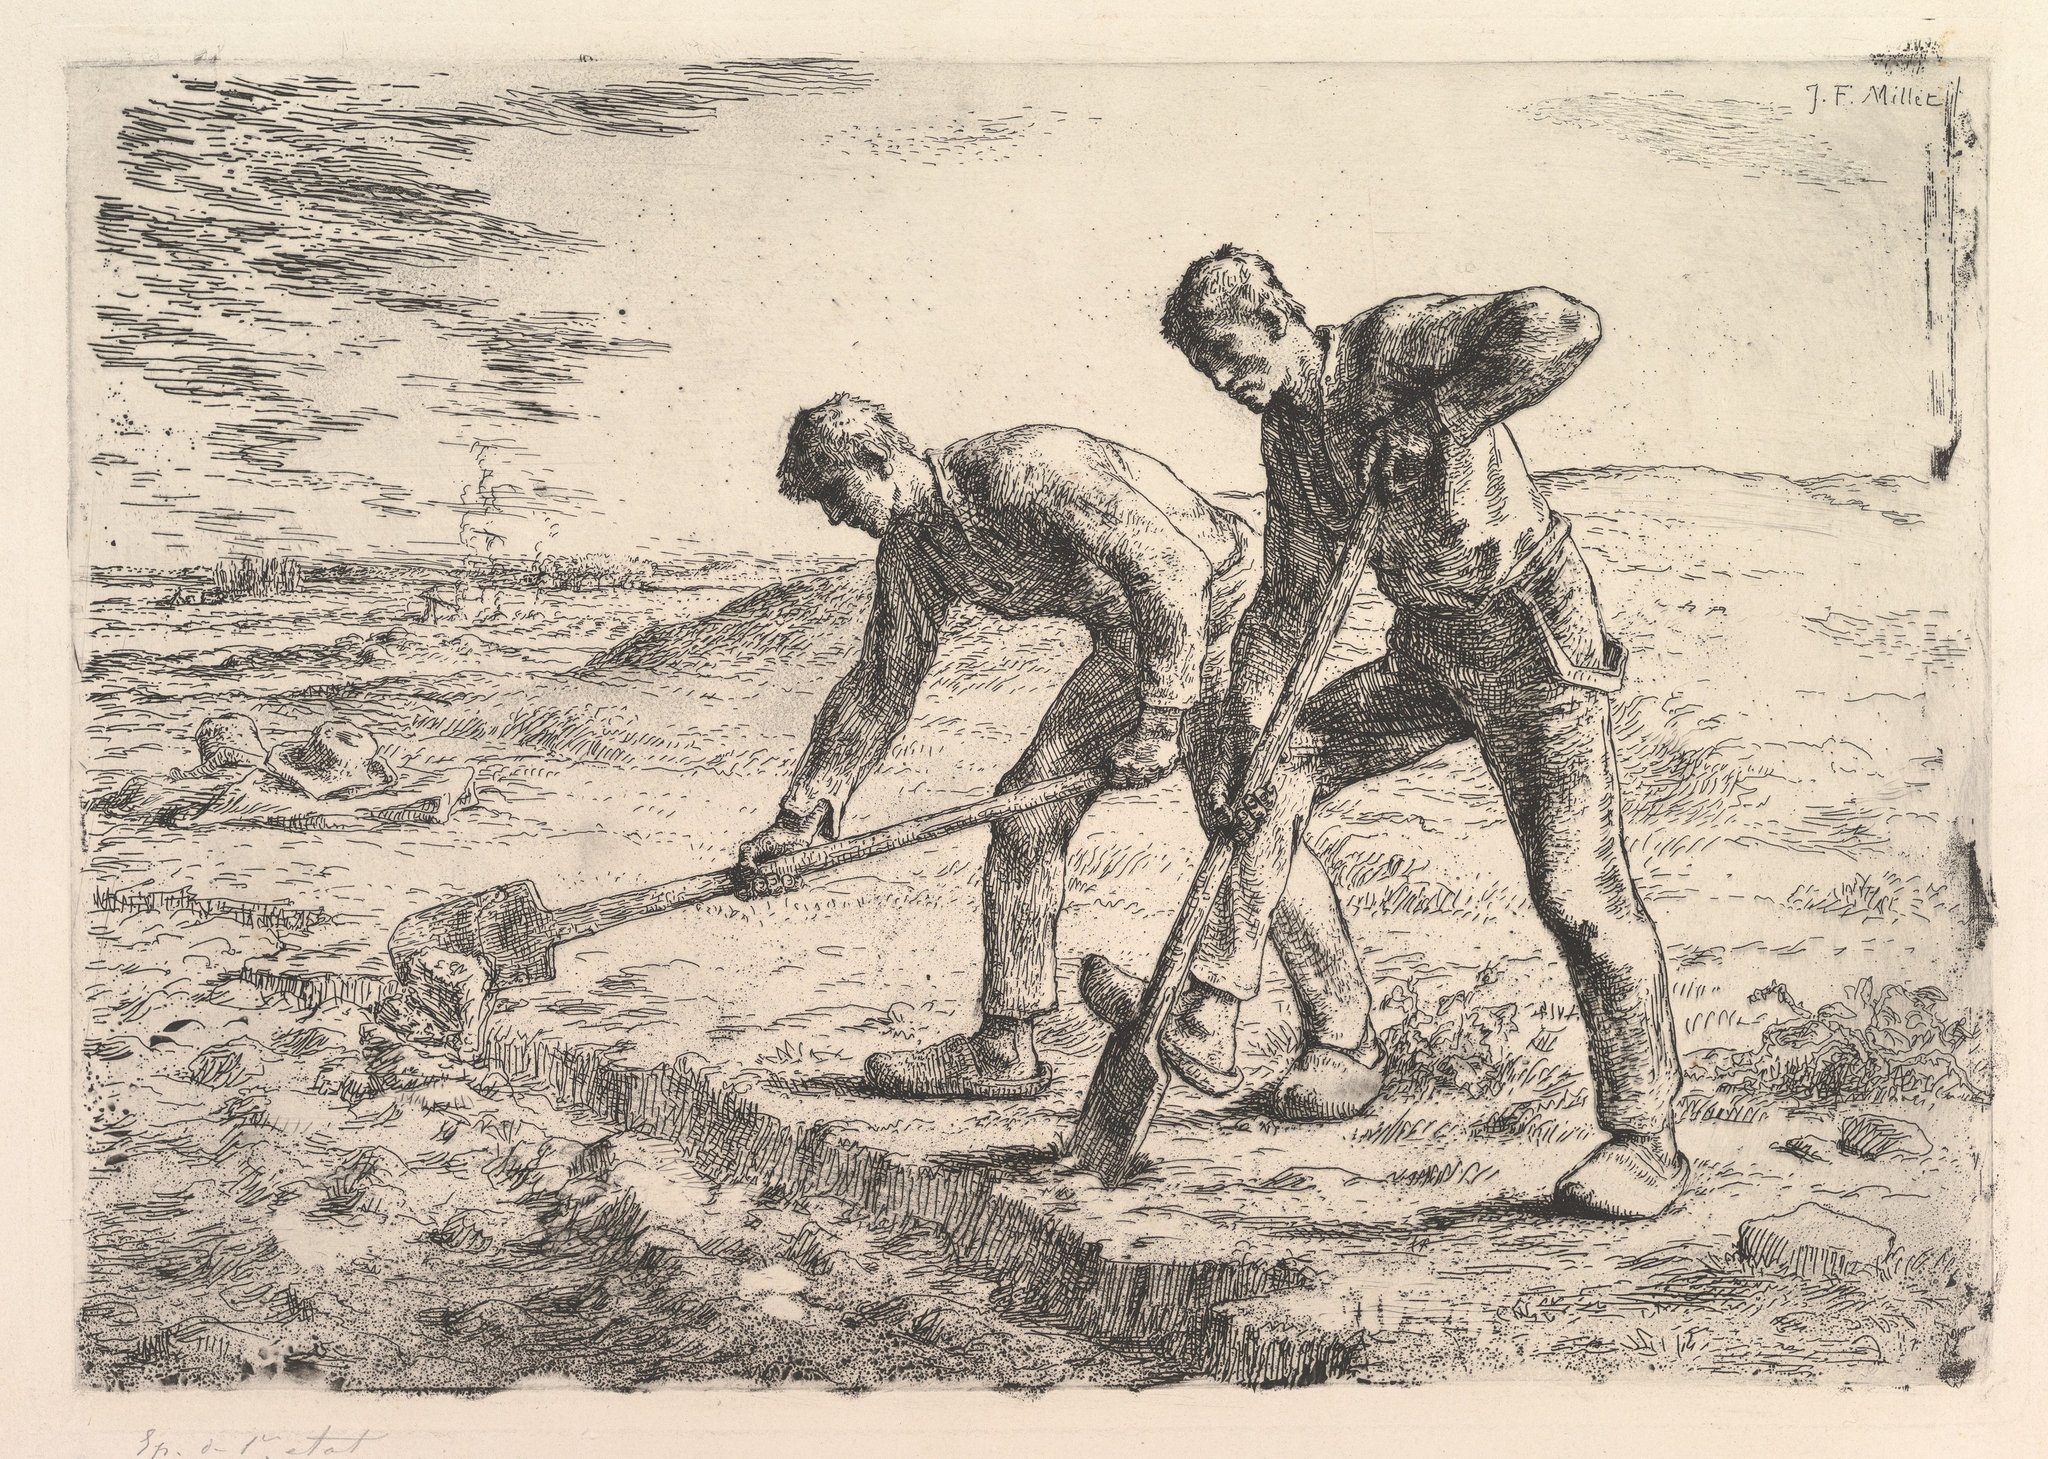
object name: print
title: The Diggers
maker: jean-françois millet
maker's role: artist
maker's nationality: french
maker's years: 1814-1875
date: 1830-1875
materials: paper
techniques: etching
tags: men,working